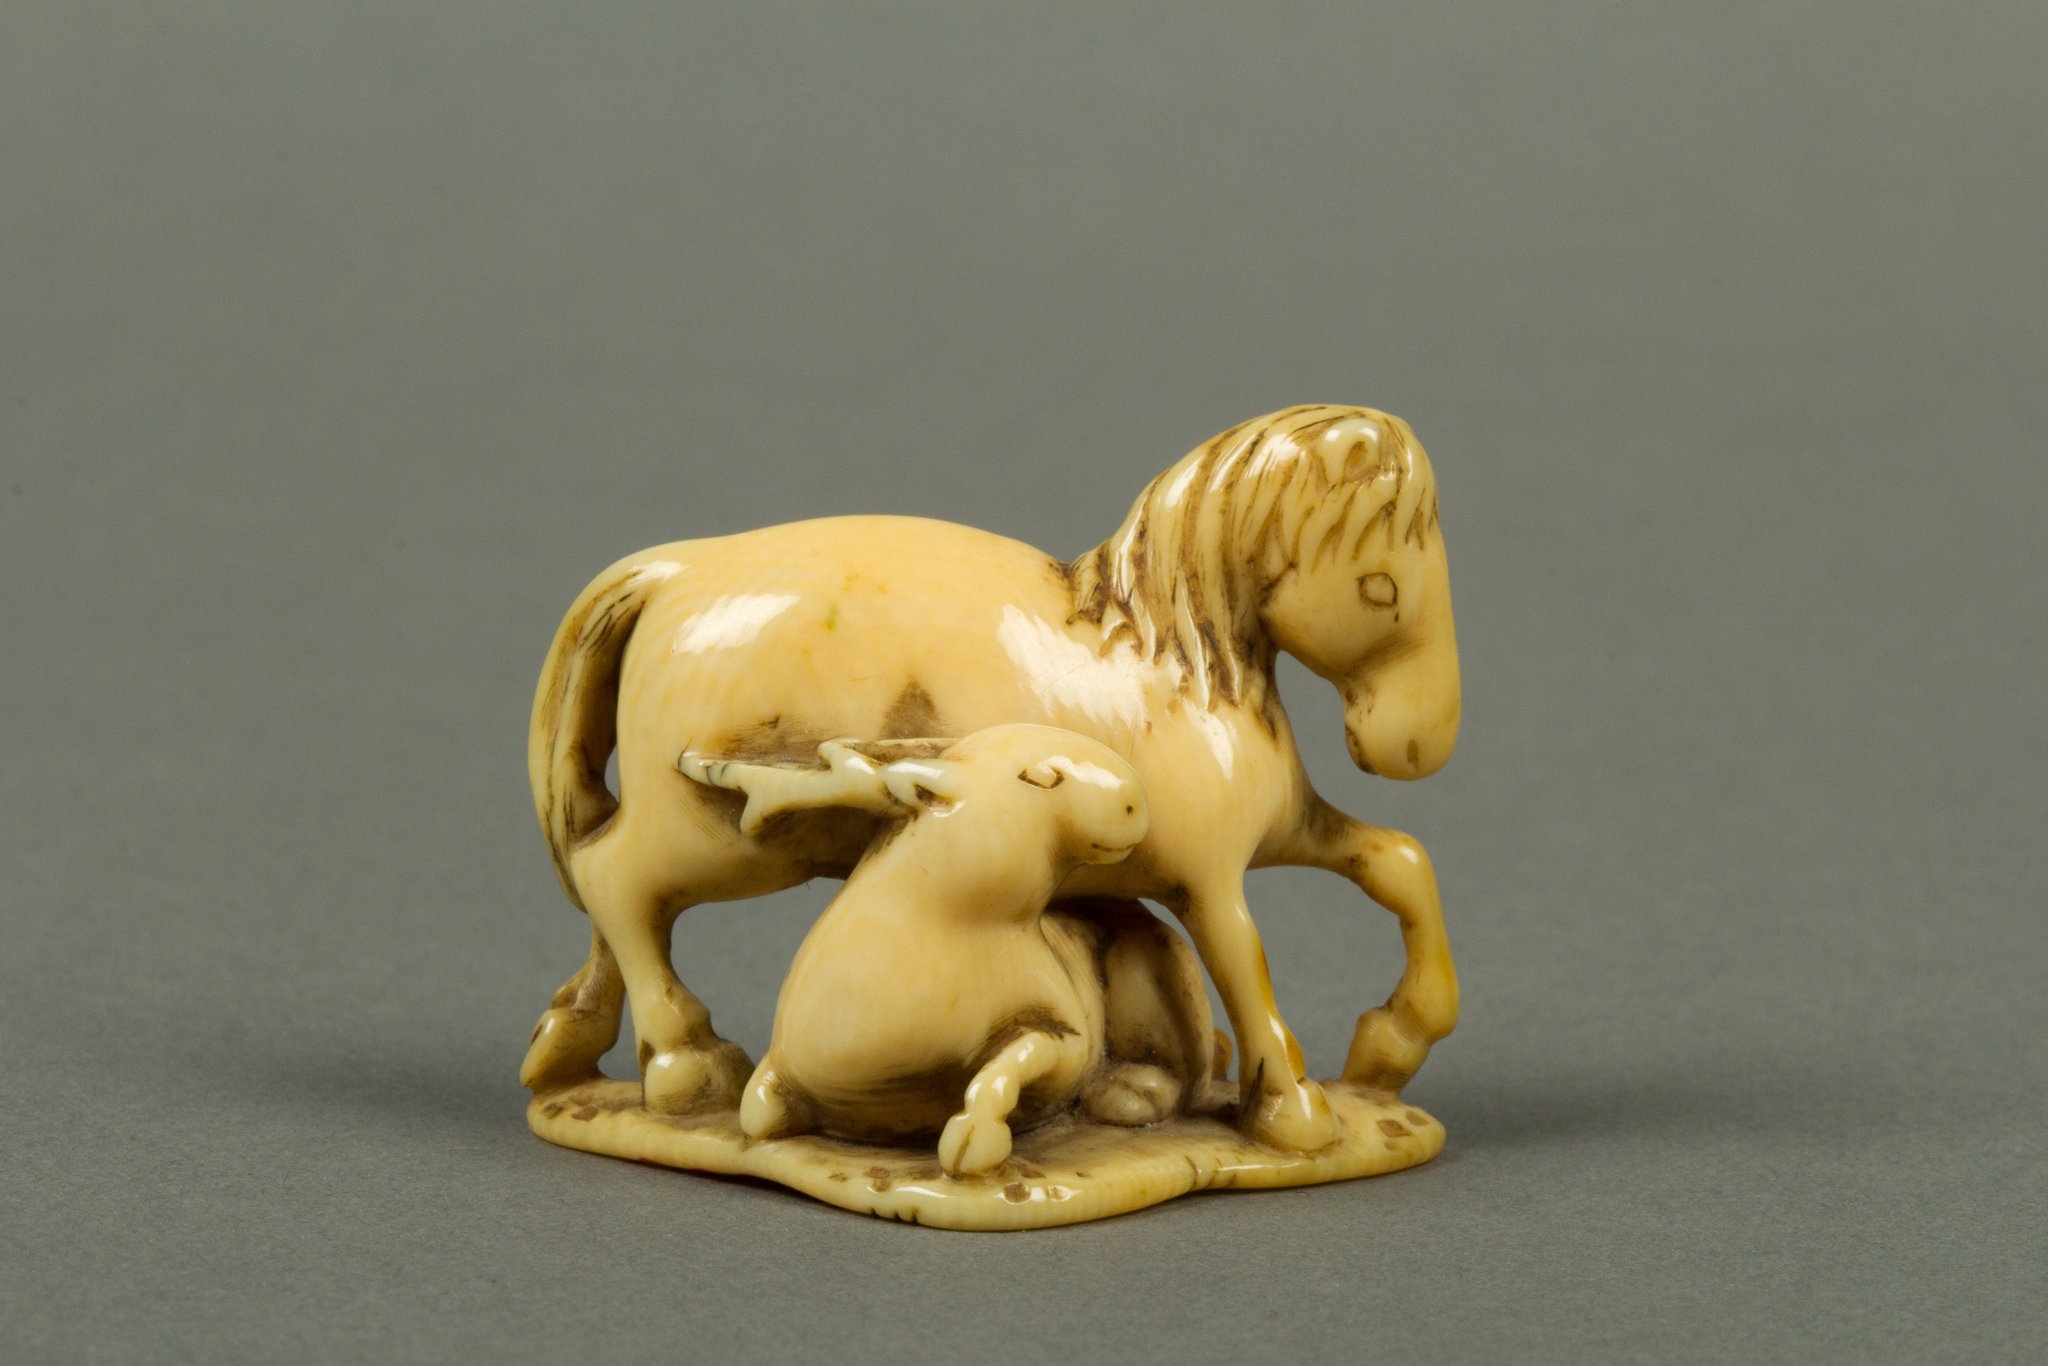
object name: netsuke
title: Netsuke of Horse and Deer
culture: japanese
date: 1801-1900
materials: ivory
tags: deer